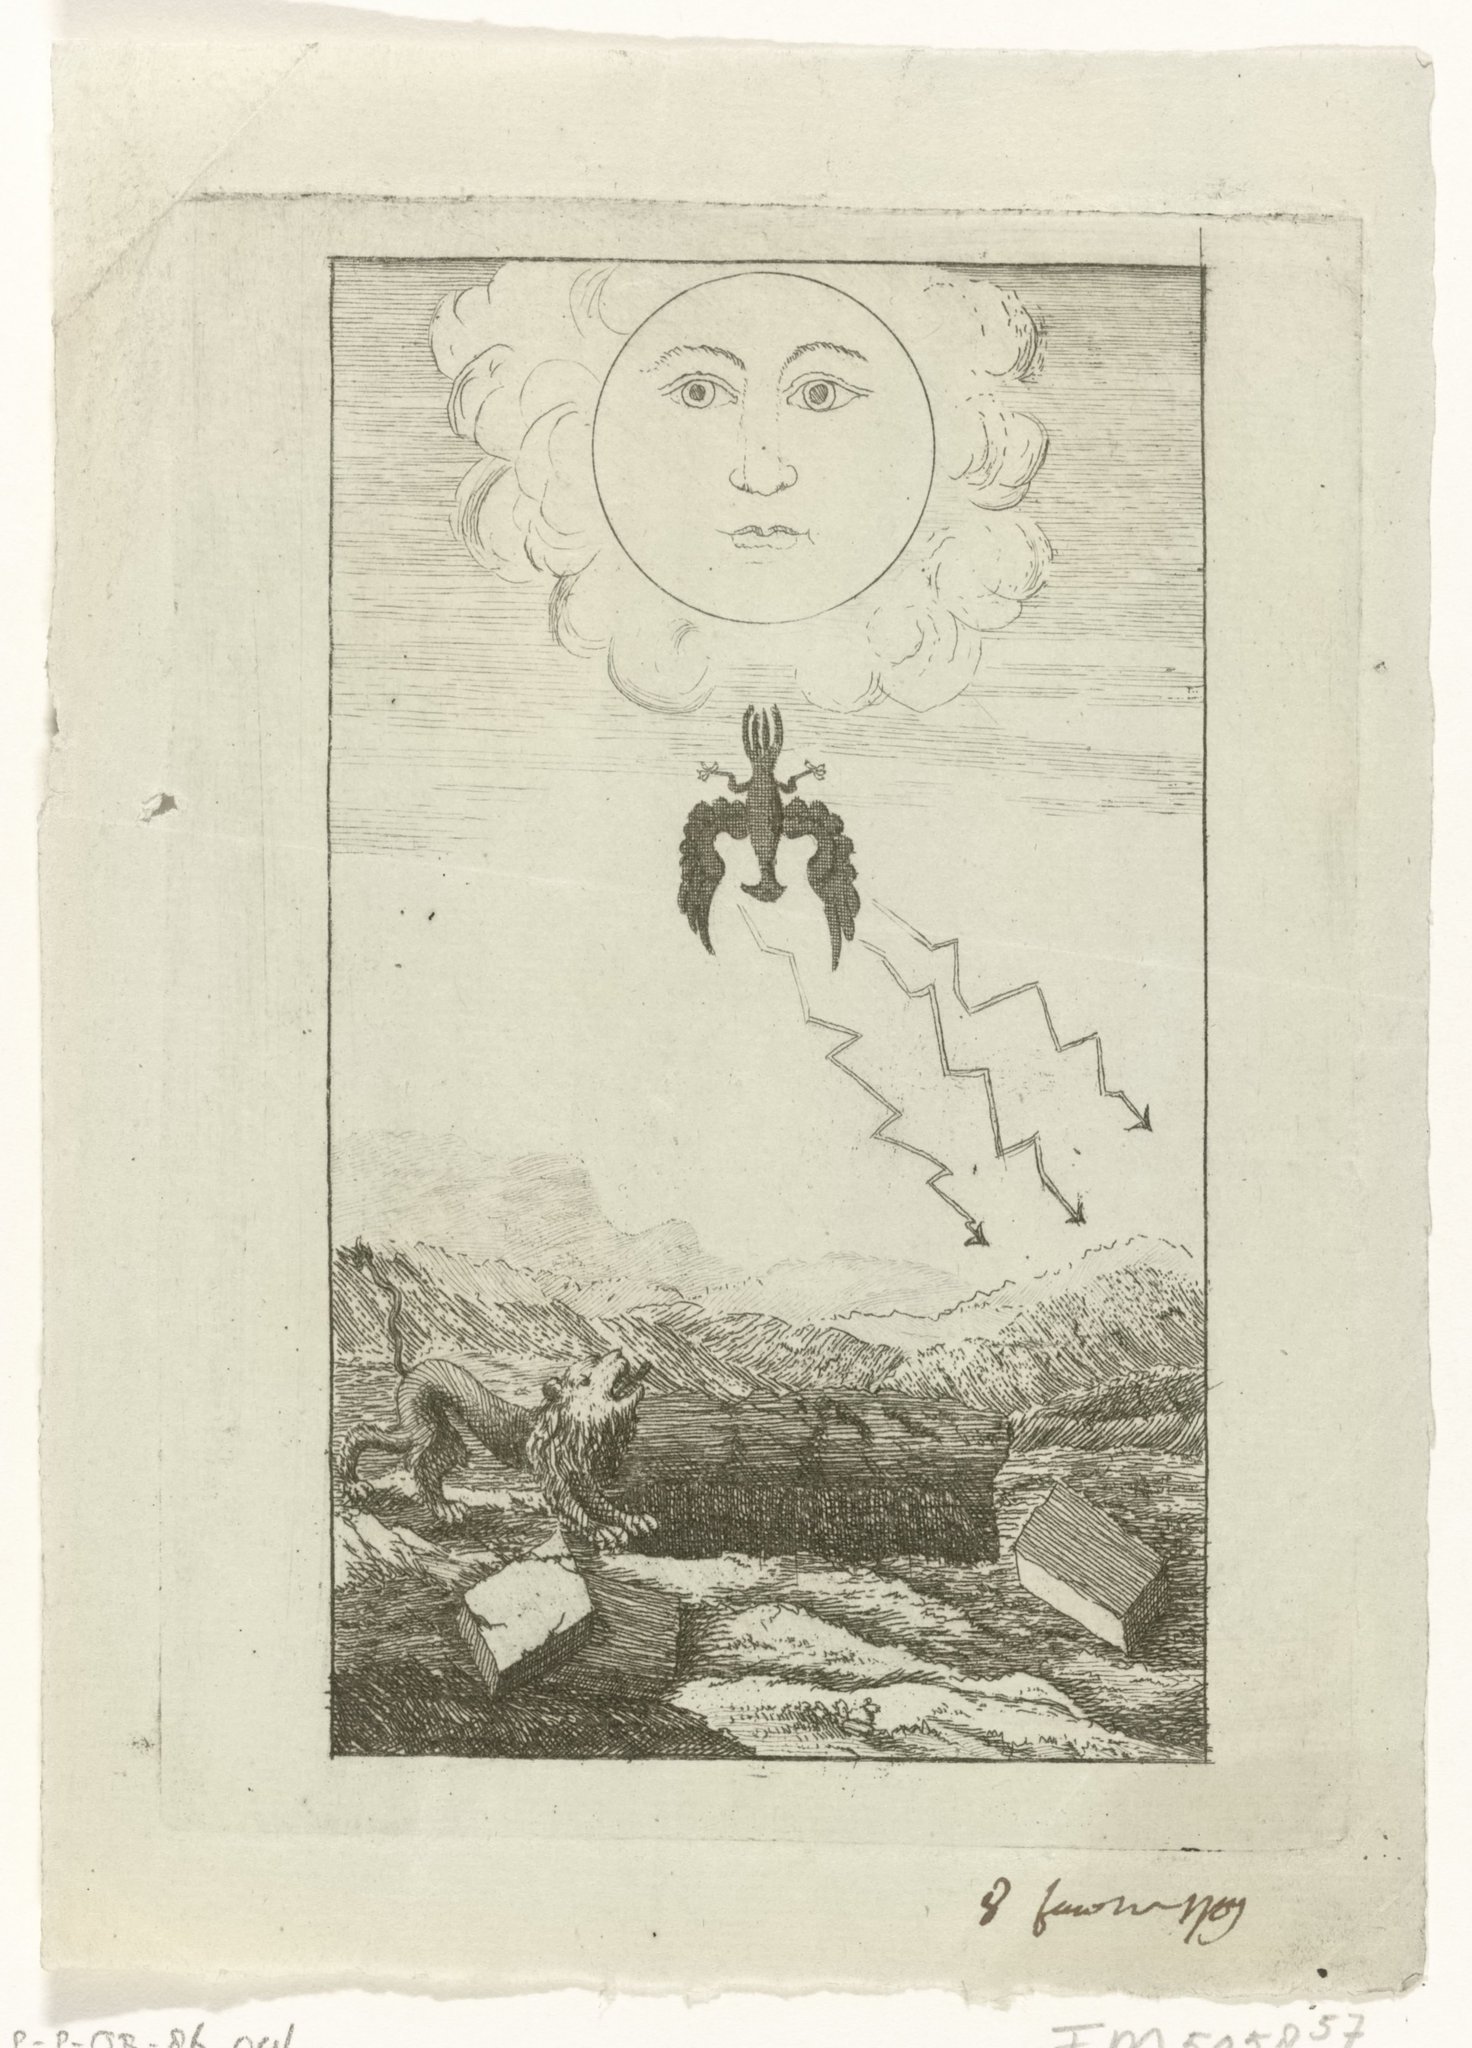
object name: cartoon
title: Oostenrijkse adelaar stort uit de hemel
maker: Anonymous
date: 1787-1790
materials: paper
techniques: engraving, etching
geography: southern netherlands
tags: brabant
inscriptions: collector's mark: Lugt 2228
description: Spotprent waarin de Oostenrijkse adelaar met bliksemschichten uit de hemel stort. Op de grond wacht de Brabantse leeuw bij een kuil. Hierbij de datum 8 februari 1789 met de hand geschreven. Onderdeel van een grote groep van prenten betrekking hebbend op de gebeurtenissen van de Brabantse Omwenteling en de periode 1787-1790.